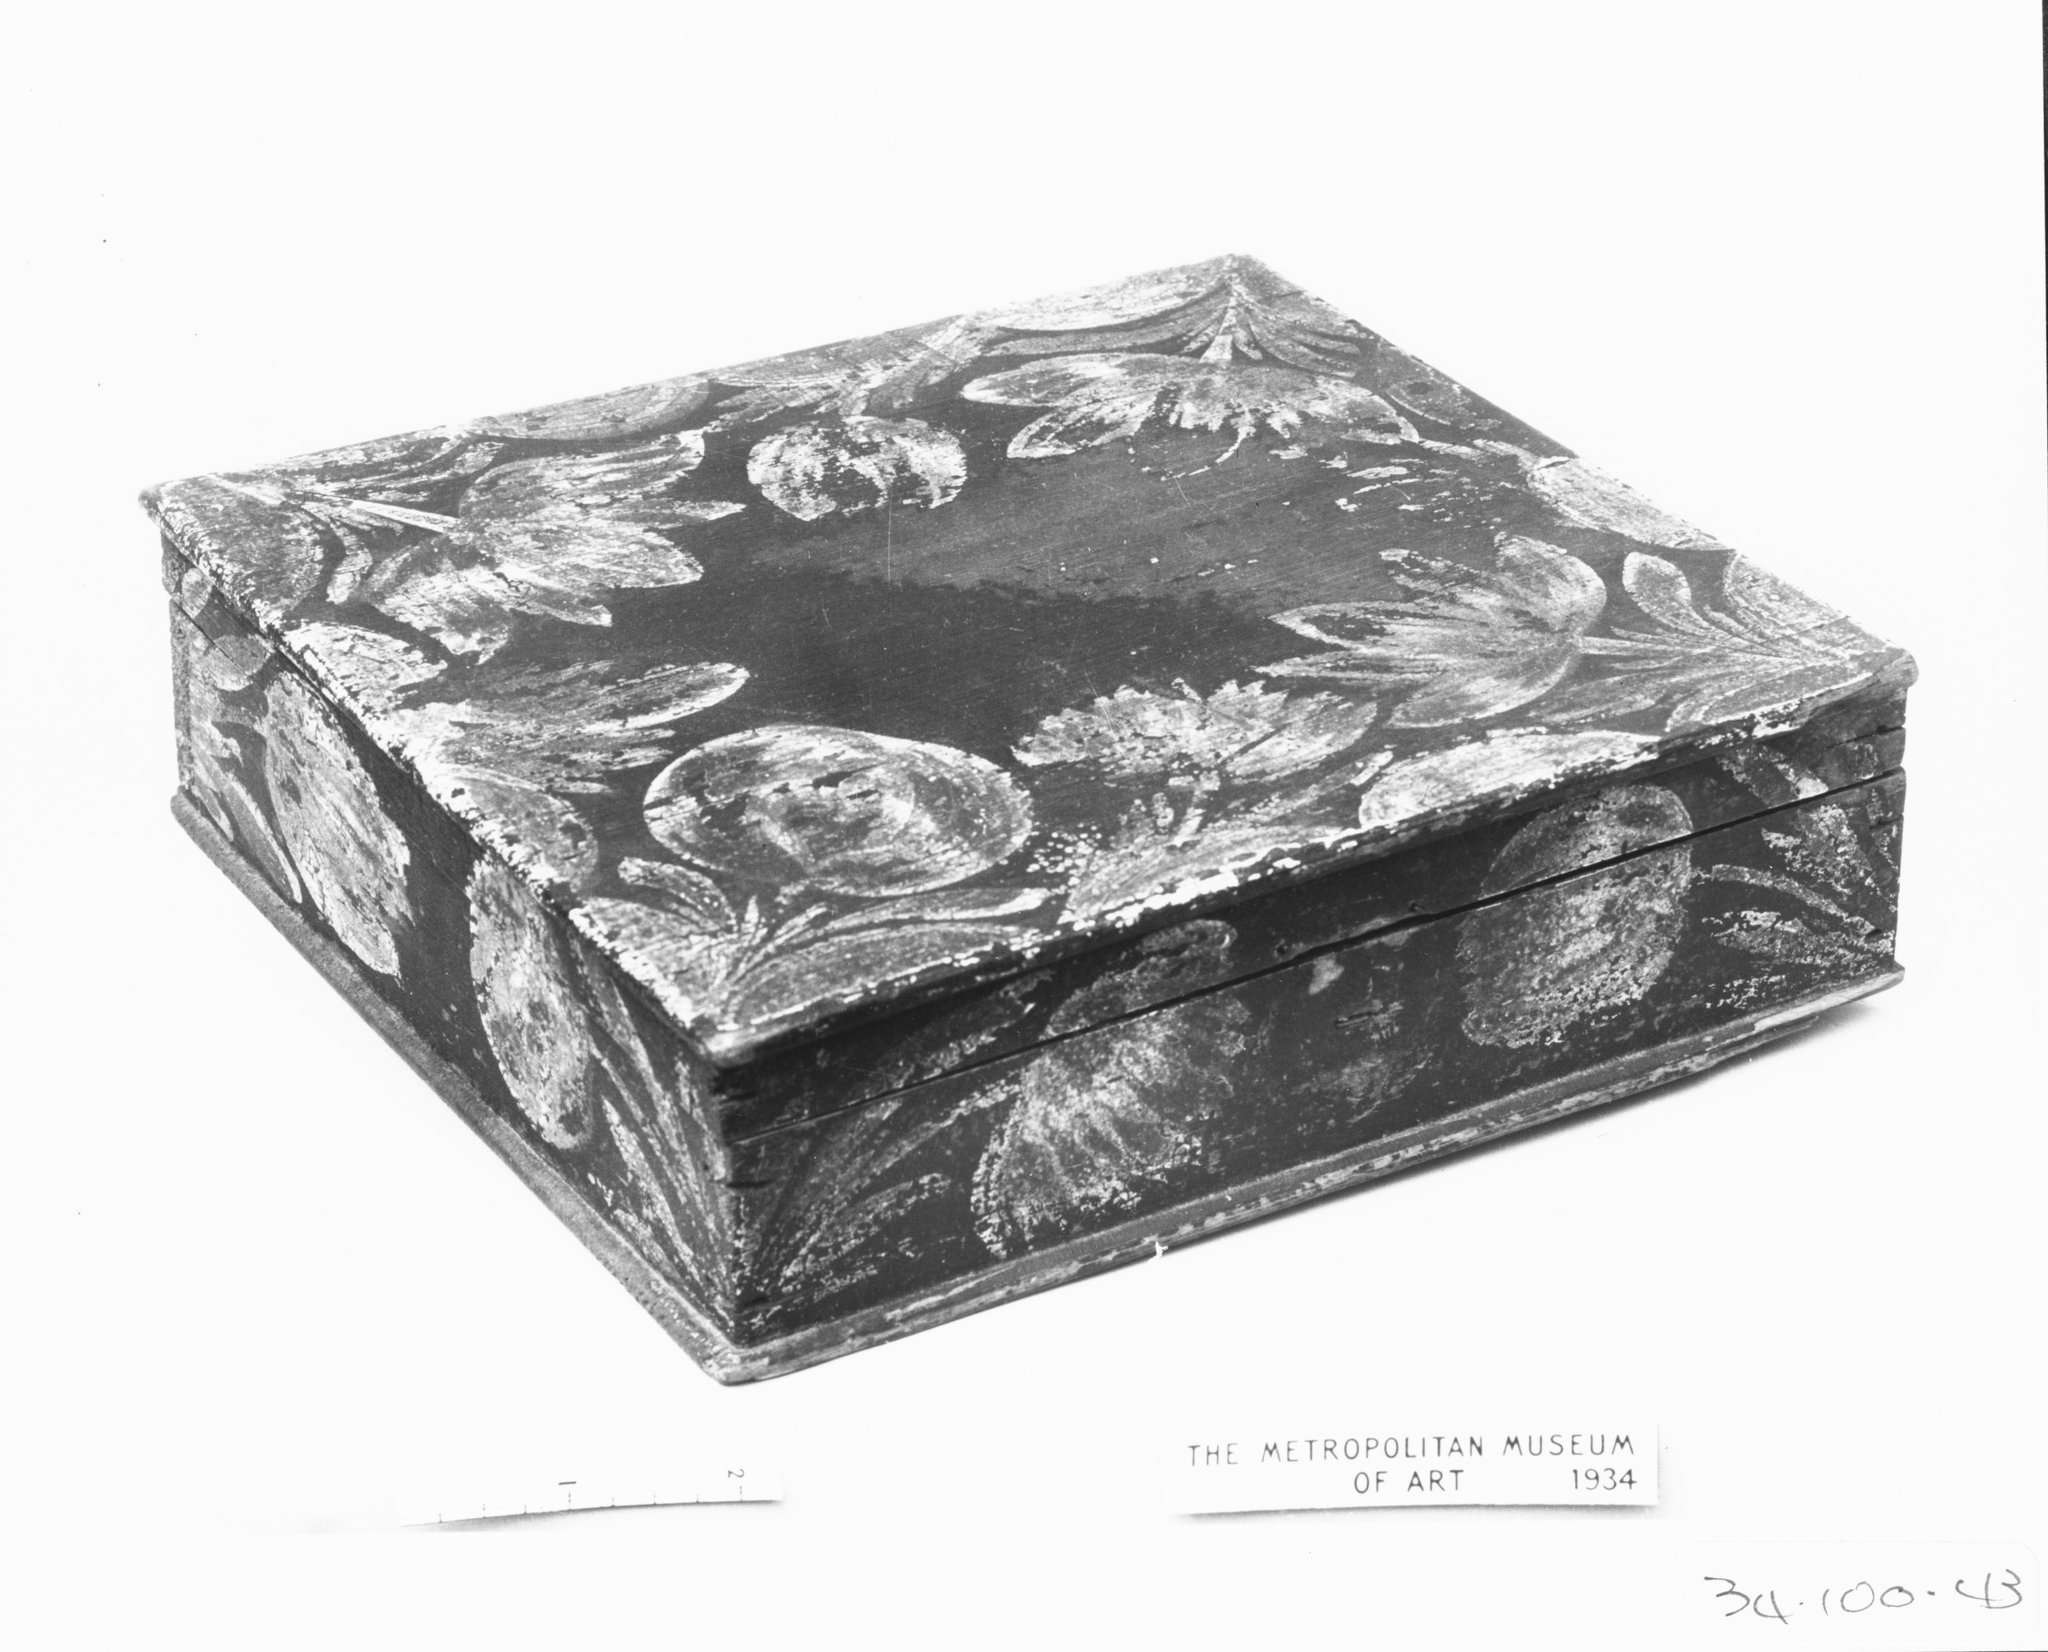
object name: trinket box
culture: american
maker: henry bucher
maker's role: maker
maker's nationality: american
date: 1780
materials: wood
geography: united states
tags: flowers